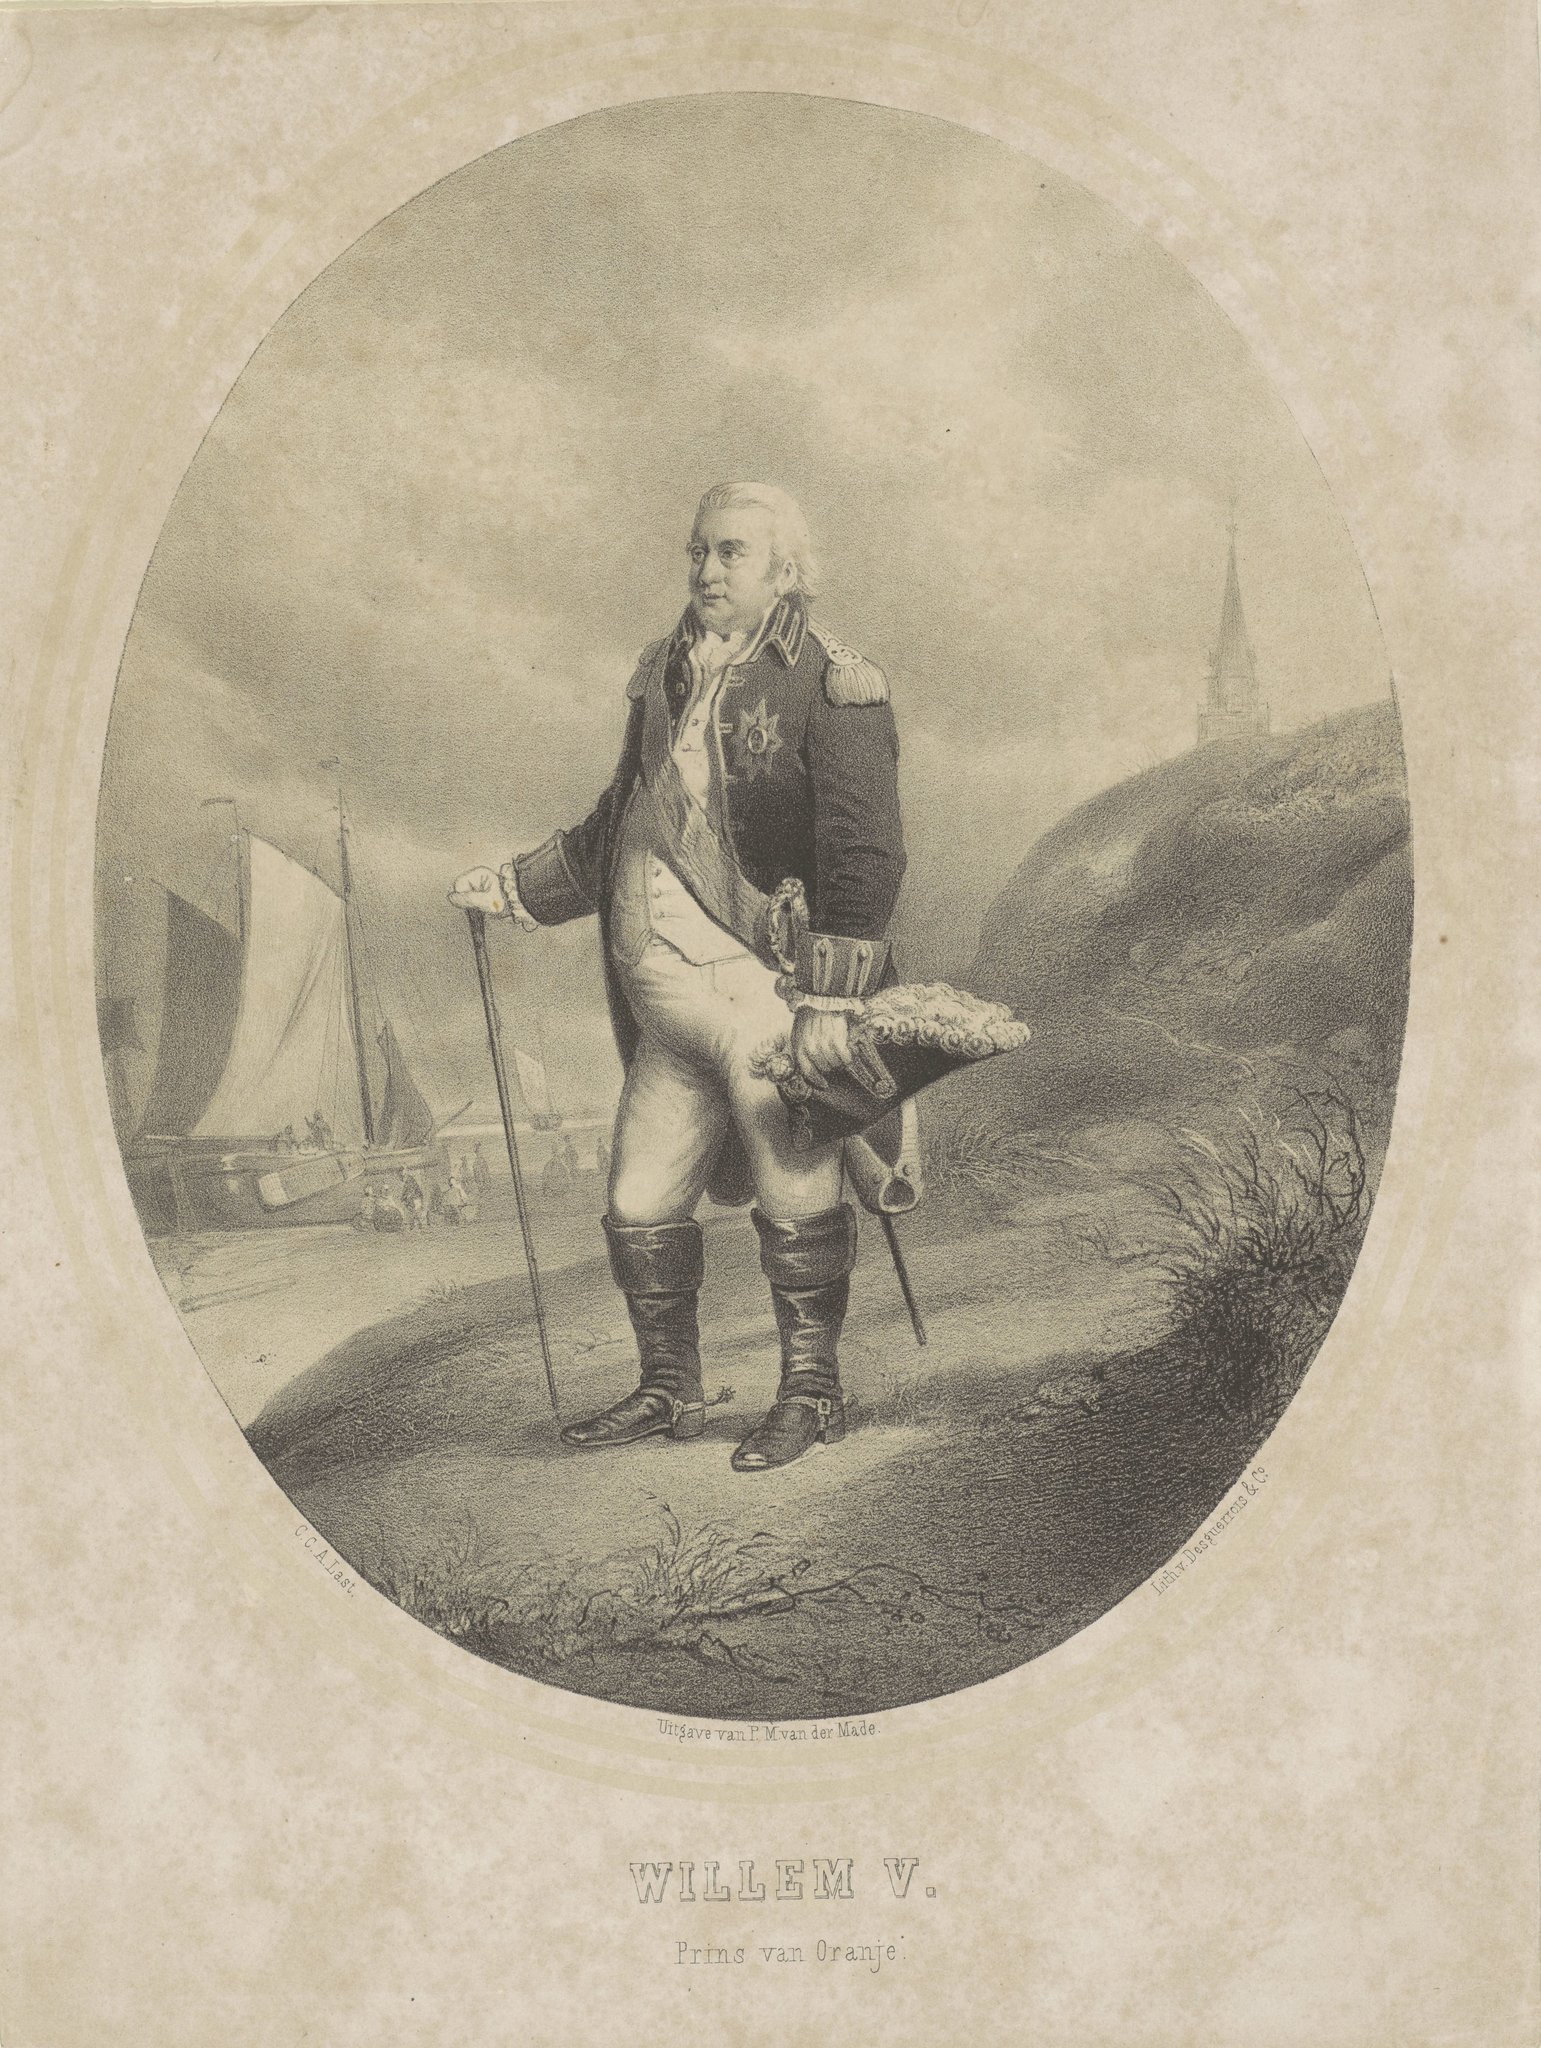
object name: print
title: Portret van Willem V, prins van Oranje-Nassau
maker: carel christiaan antony last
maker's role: print maker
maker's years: 1808-1876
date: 1857-1873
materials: paper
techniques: tone lithography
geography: amsterdam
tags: william v (prince of orange)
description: De hier vermelde titel verwijst naar de hoogst verkregen titel van de geportretteerde, niet per se naar de titel die de geportretteerde op deze voorstelling draagt.